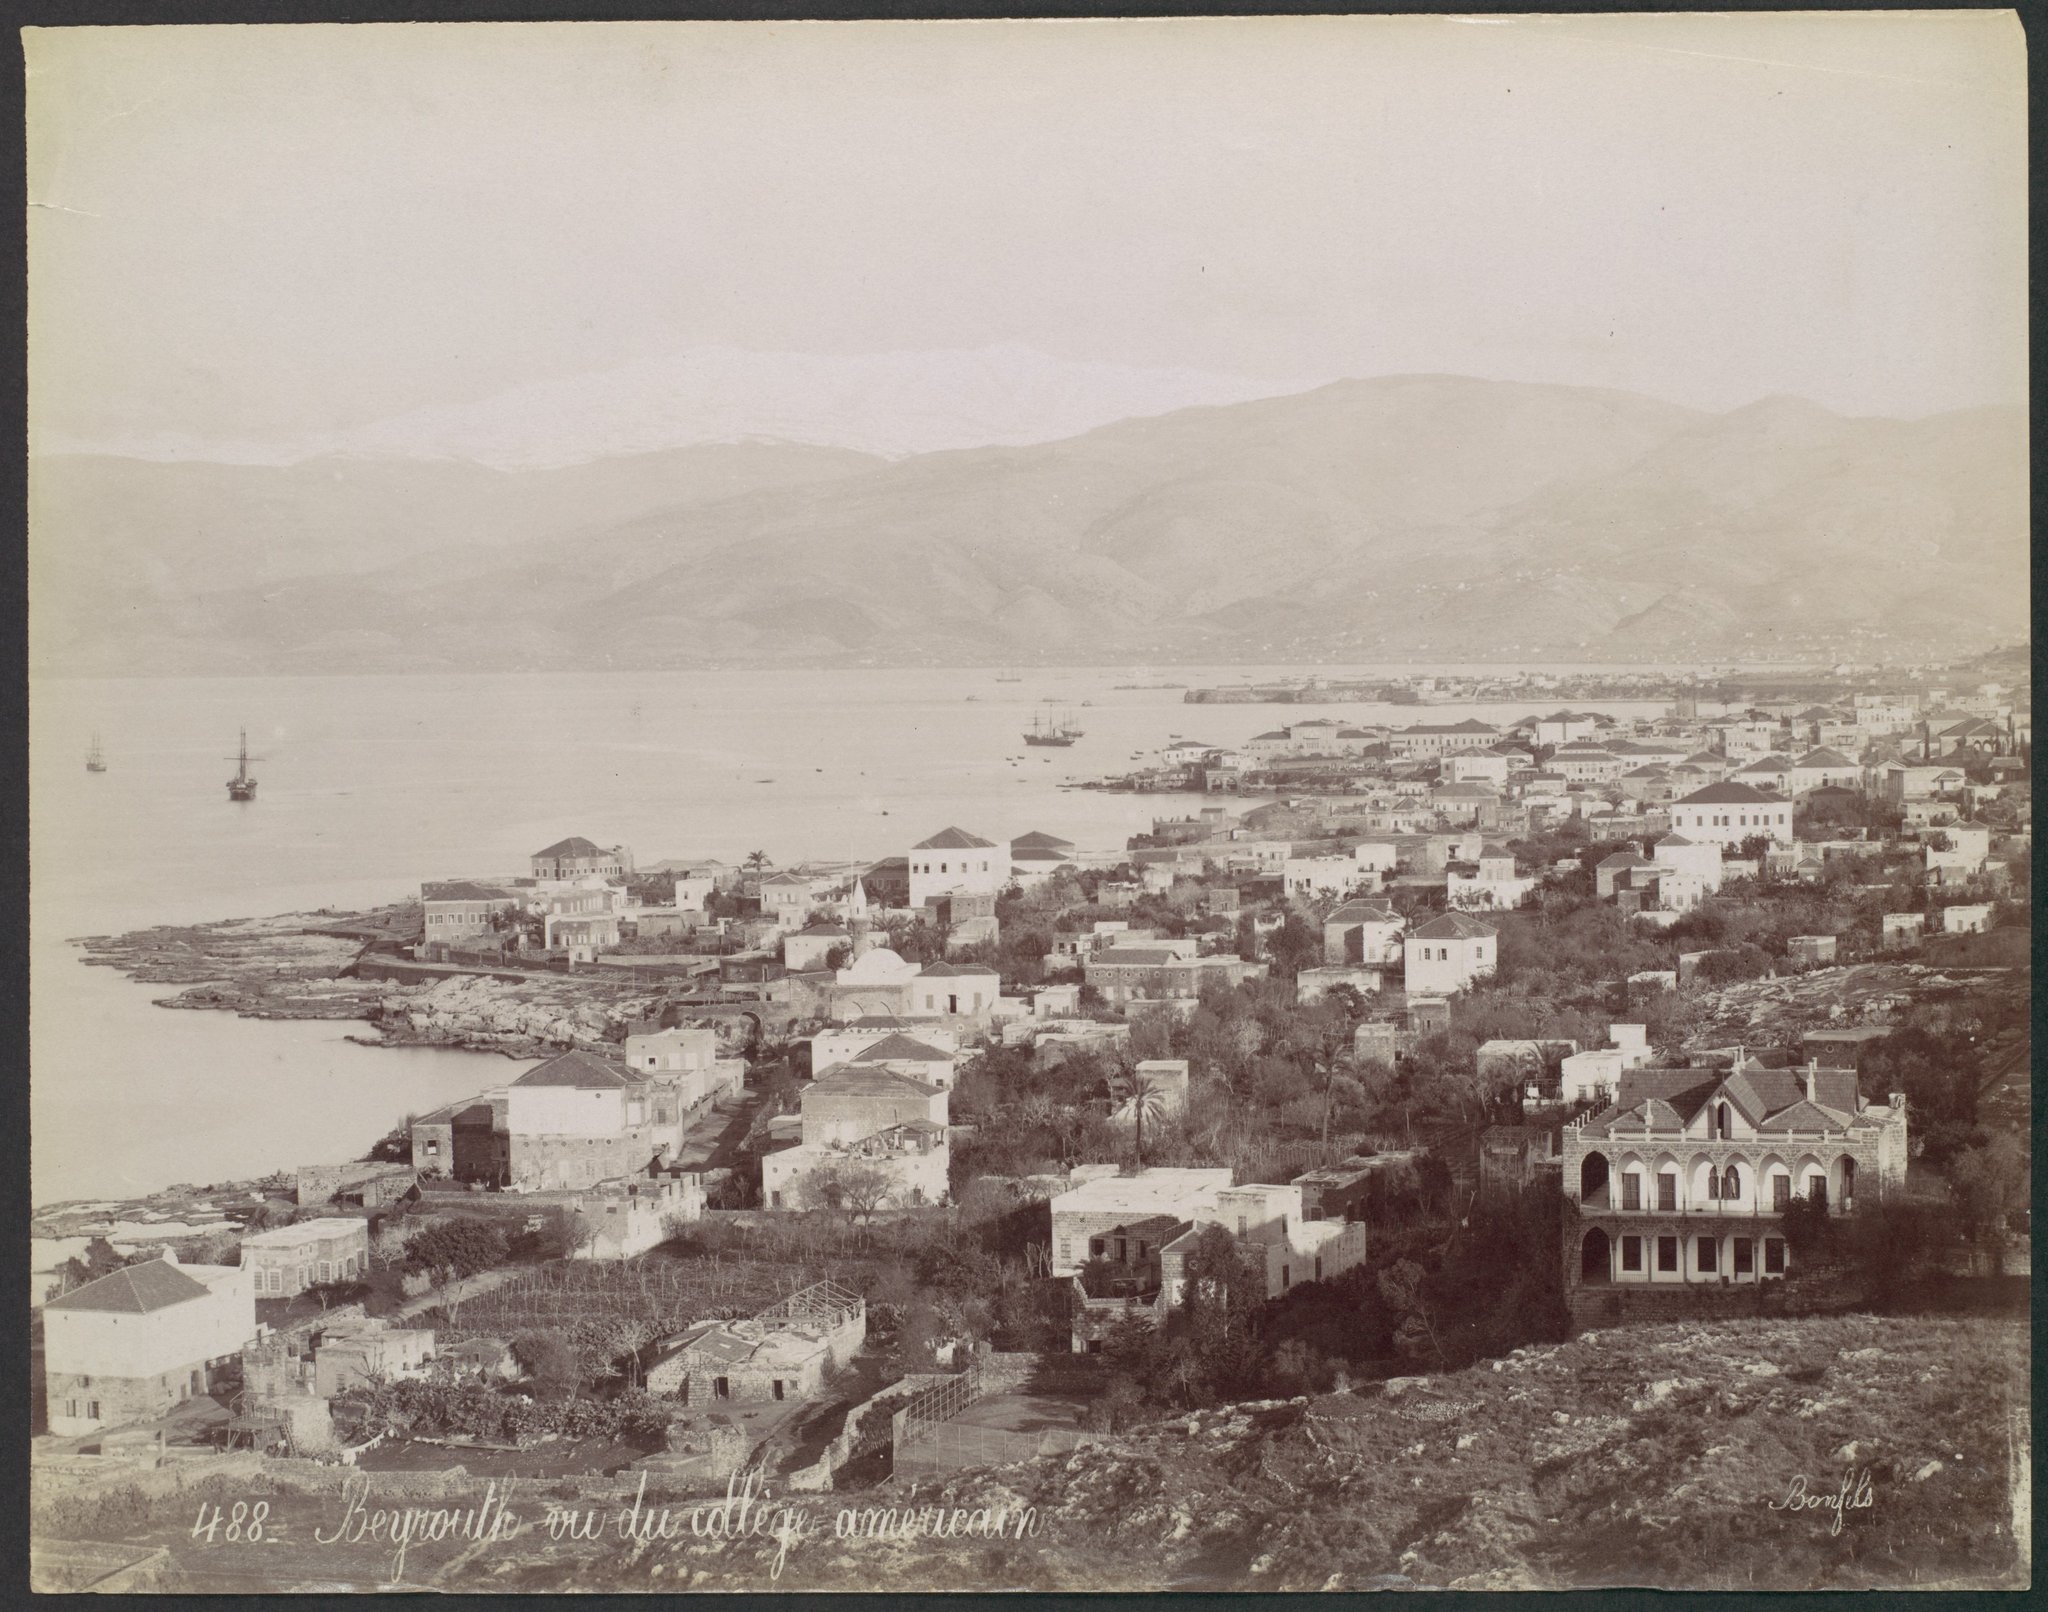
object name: photograph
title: Beyrouth. Vu du collège américain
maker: félix bonfils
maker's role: fotograaf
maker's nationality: french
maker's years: 1831-1885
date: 1870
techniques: albumen silver print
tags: towns,mountains,boats